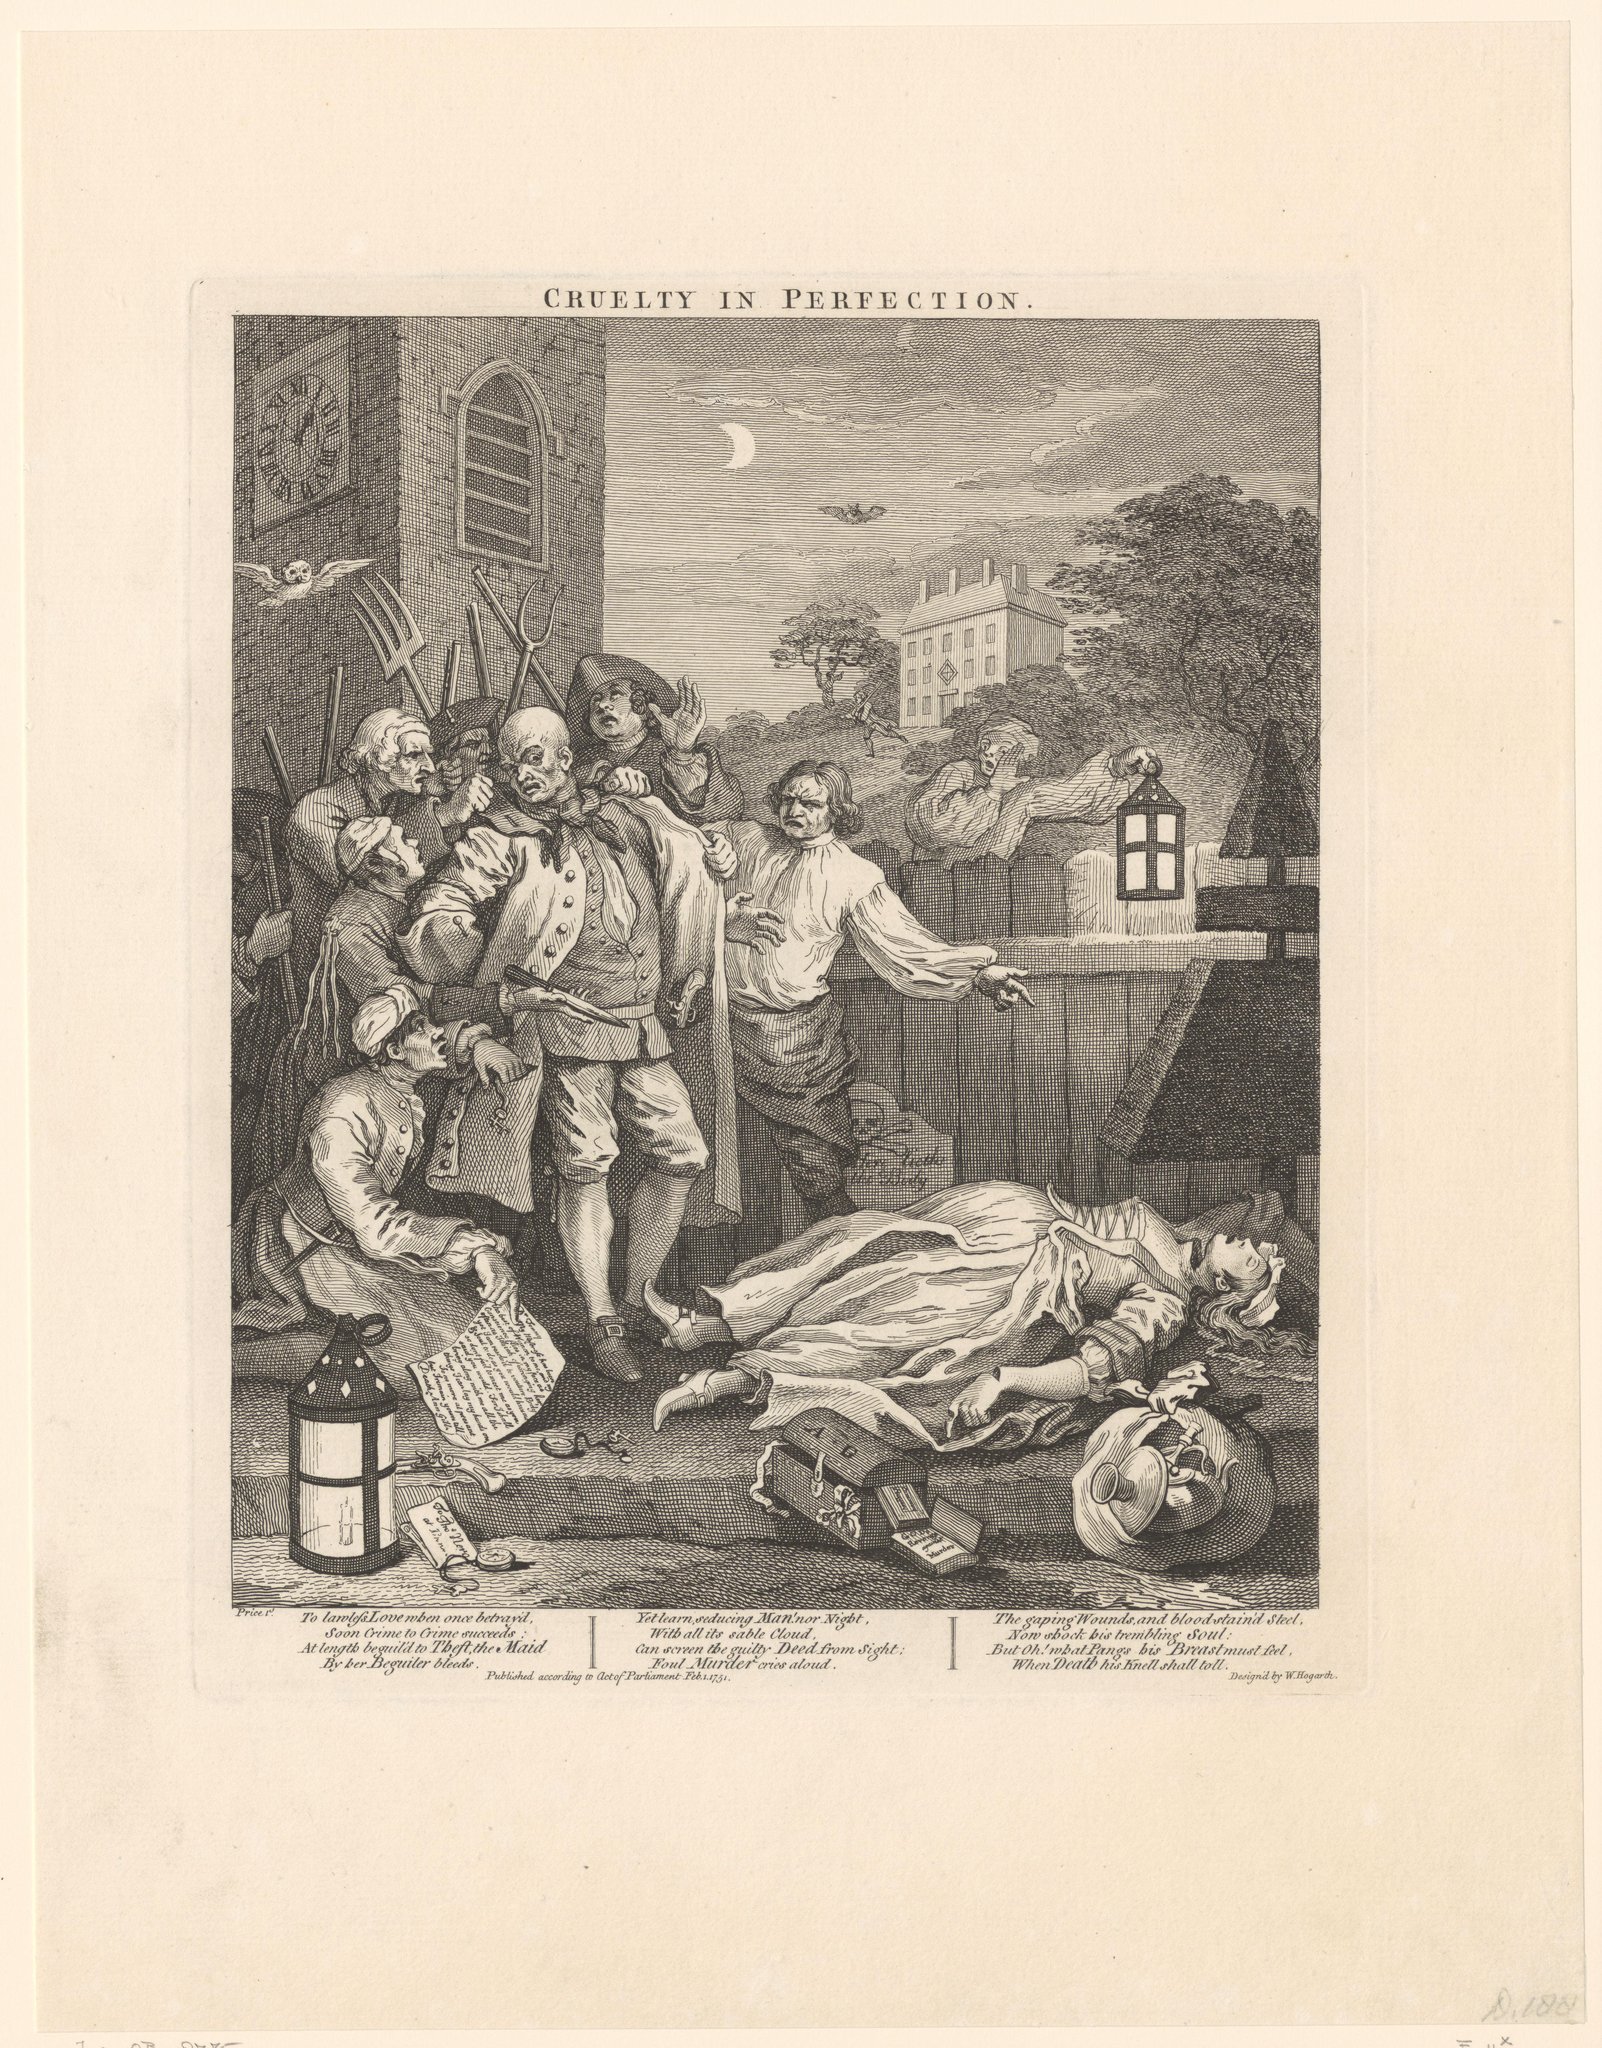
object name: print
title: De vier stadia van wreedheid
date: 1751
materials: paper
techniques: engraving, etching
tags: murder, adultery, (story of) nero, the roman emperor, cruelty, ferocity; 'crudeltà', 'ferocità' (ripa)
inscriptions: collector's mark: Lugt 2228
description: Deze serie weergeeft vier stadia van wreedheid: bewuste, onbewuste en geplande wreedheid en sadisme. Hogarth verwijst naar de fictieve Tom Nero en zijn wrede gedachtegoed door in alle prenten impliciet of expliciet naar hem te verwijzen.